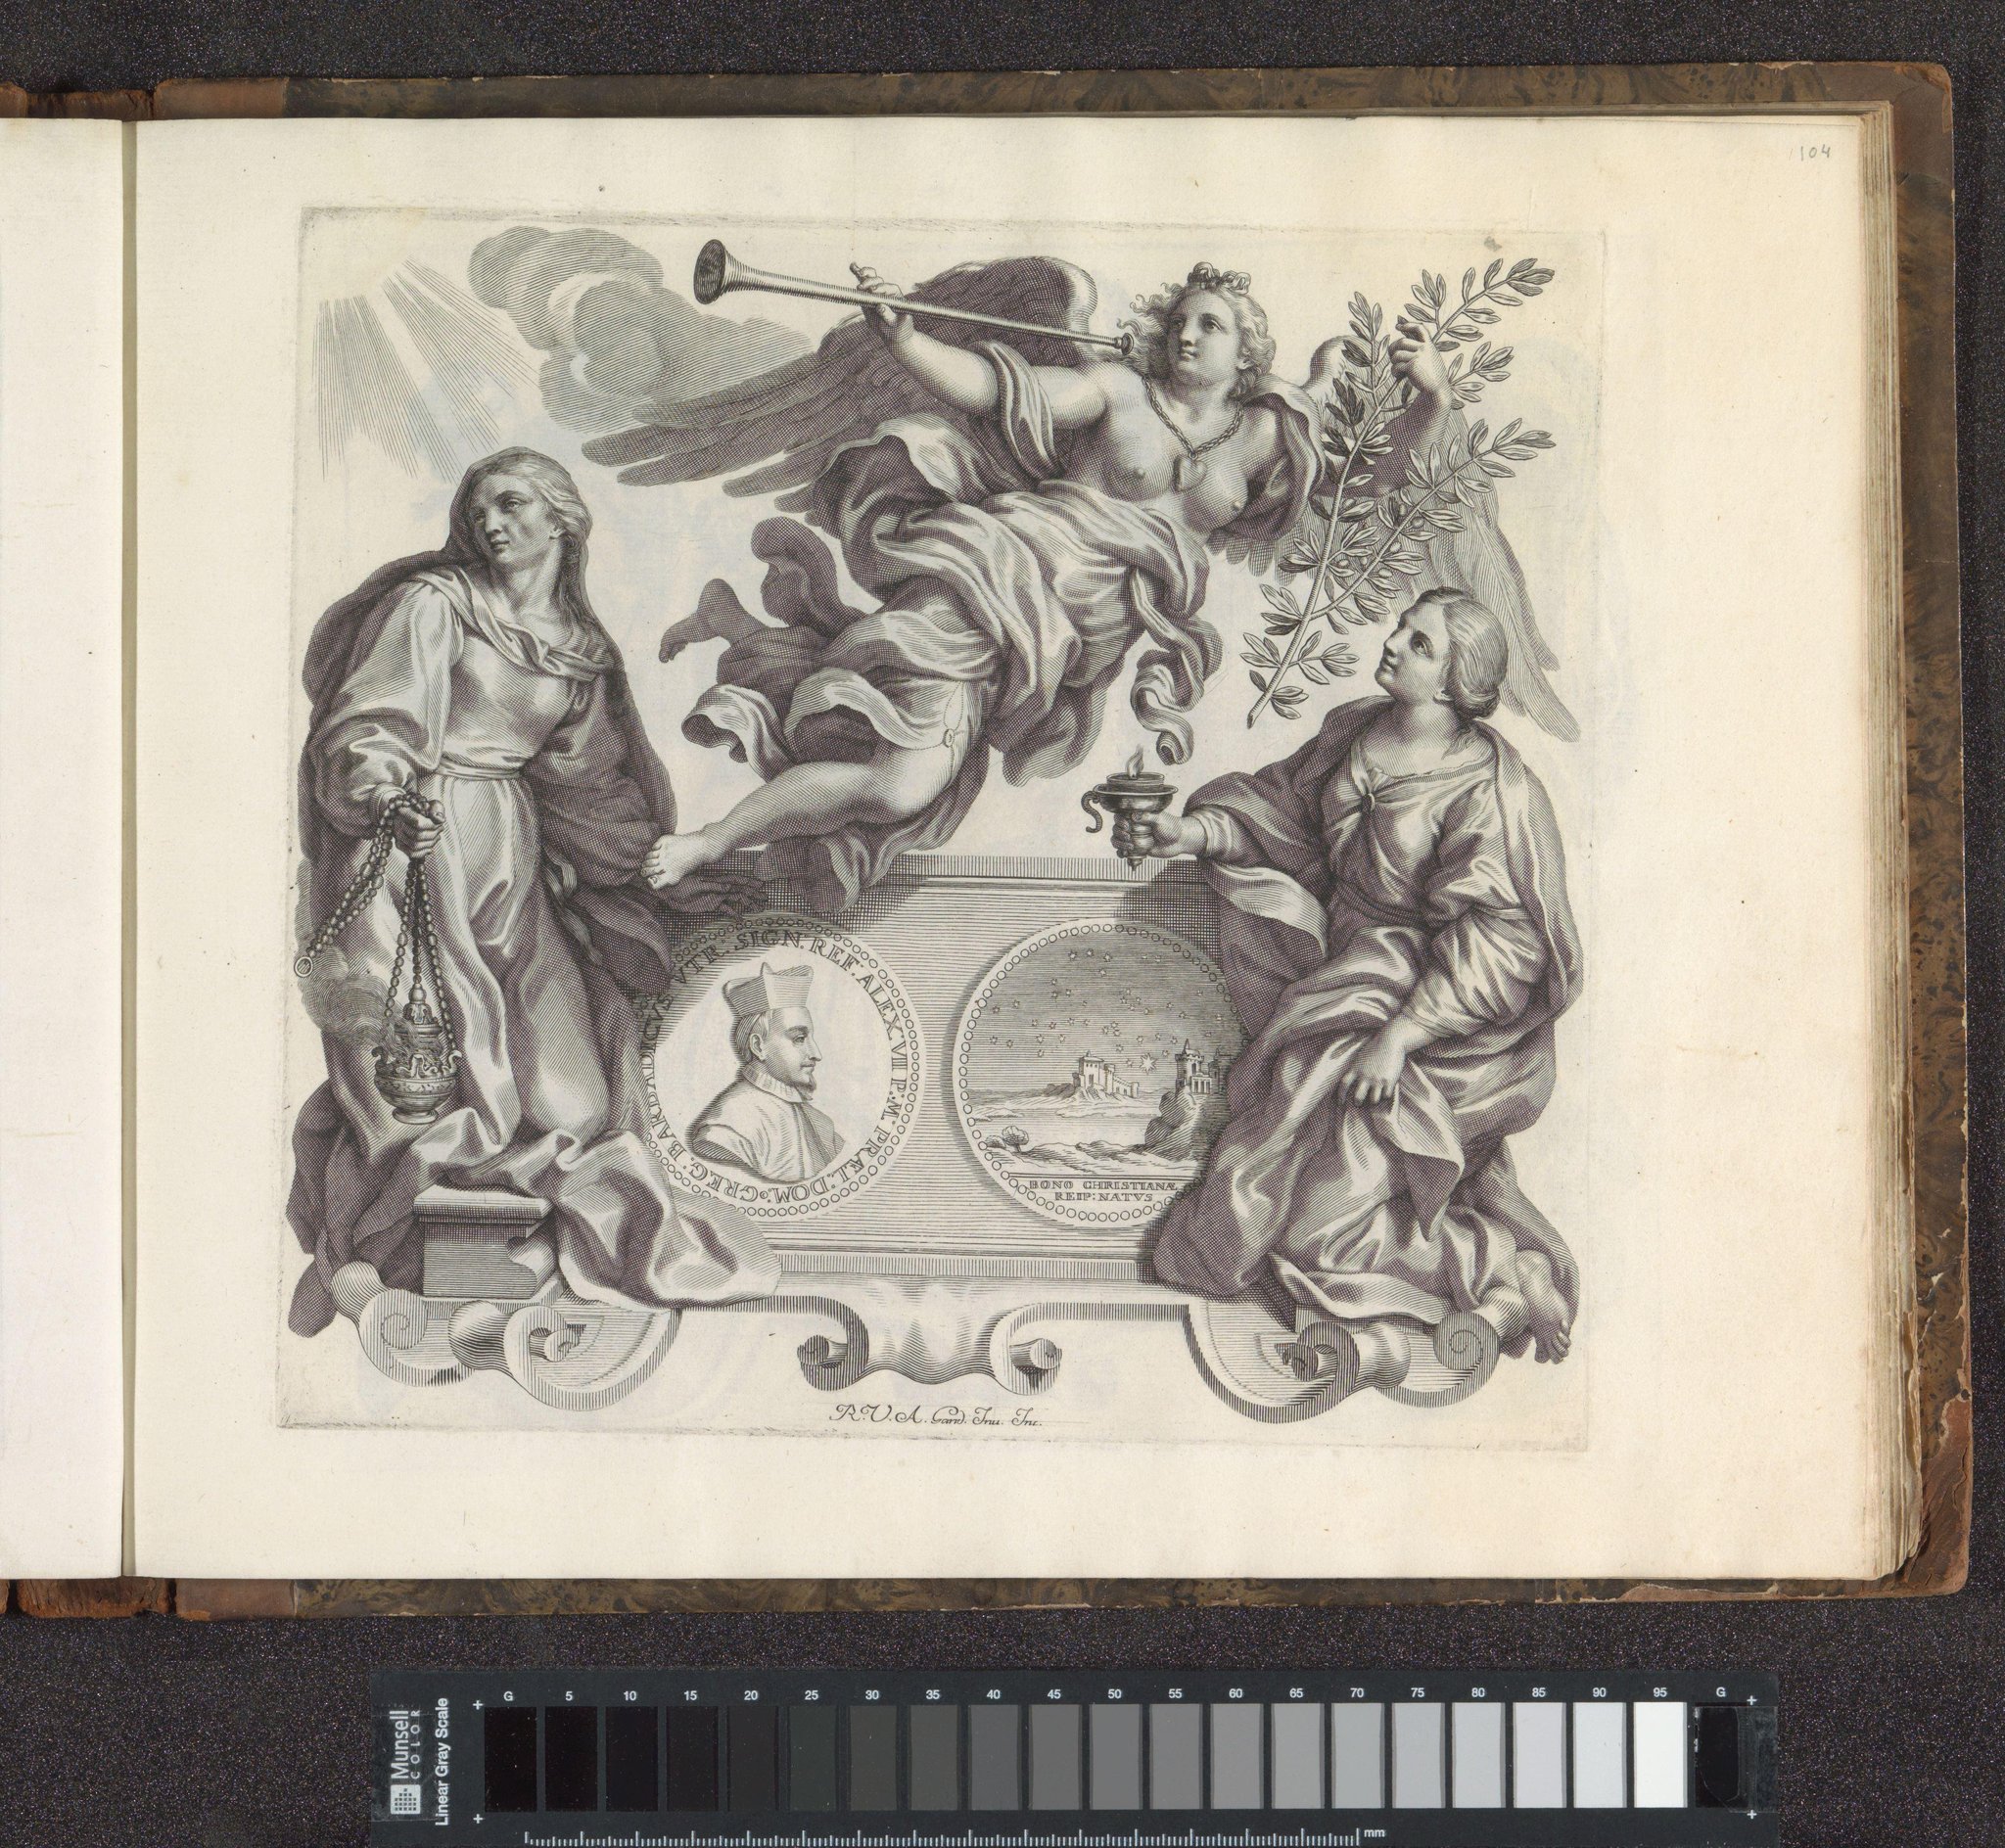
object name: print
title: Portret van Gregorio Barbarigo en de personificaties van Gebed, Goed Gerucht en Religie-ijver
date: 1673-1743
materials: paper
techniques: engraving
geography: rome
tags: devotion, piety; 'divotione' (ripa), symbols, allegories of peace, 'pax'; 'pace' (ripa), censer, (private) prayer; 'oratione', 'preghiere', 'preghiere a dio' (ripa), fame; 'fama', 'fama buona', 'fama chiara' (ripa)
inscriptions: collector's mark: Lugt 2228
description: Voetstuk in de vorm van een cartouche. Daarop een medaillon met op de voorkant het portret van Gregorio Barbarigo. Hij draagt een biretta op zijn hoofd. Op de achterkant twee kastelen in een nachtelijk landschap. Boven het voetstuk Faam of Goed Gerucht met trompet en olijftak en om haar nek een gouden keten met een hart. Twee vrouwen knielen. Het wierookvat van de vrouw links symboliseert de gebeden die opstijgen naar de hemel. Zij zijn de vrouwelijke personificaties van Gebed en Devotie of Religie-ijver. De prent maakt deel uit van een album.